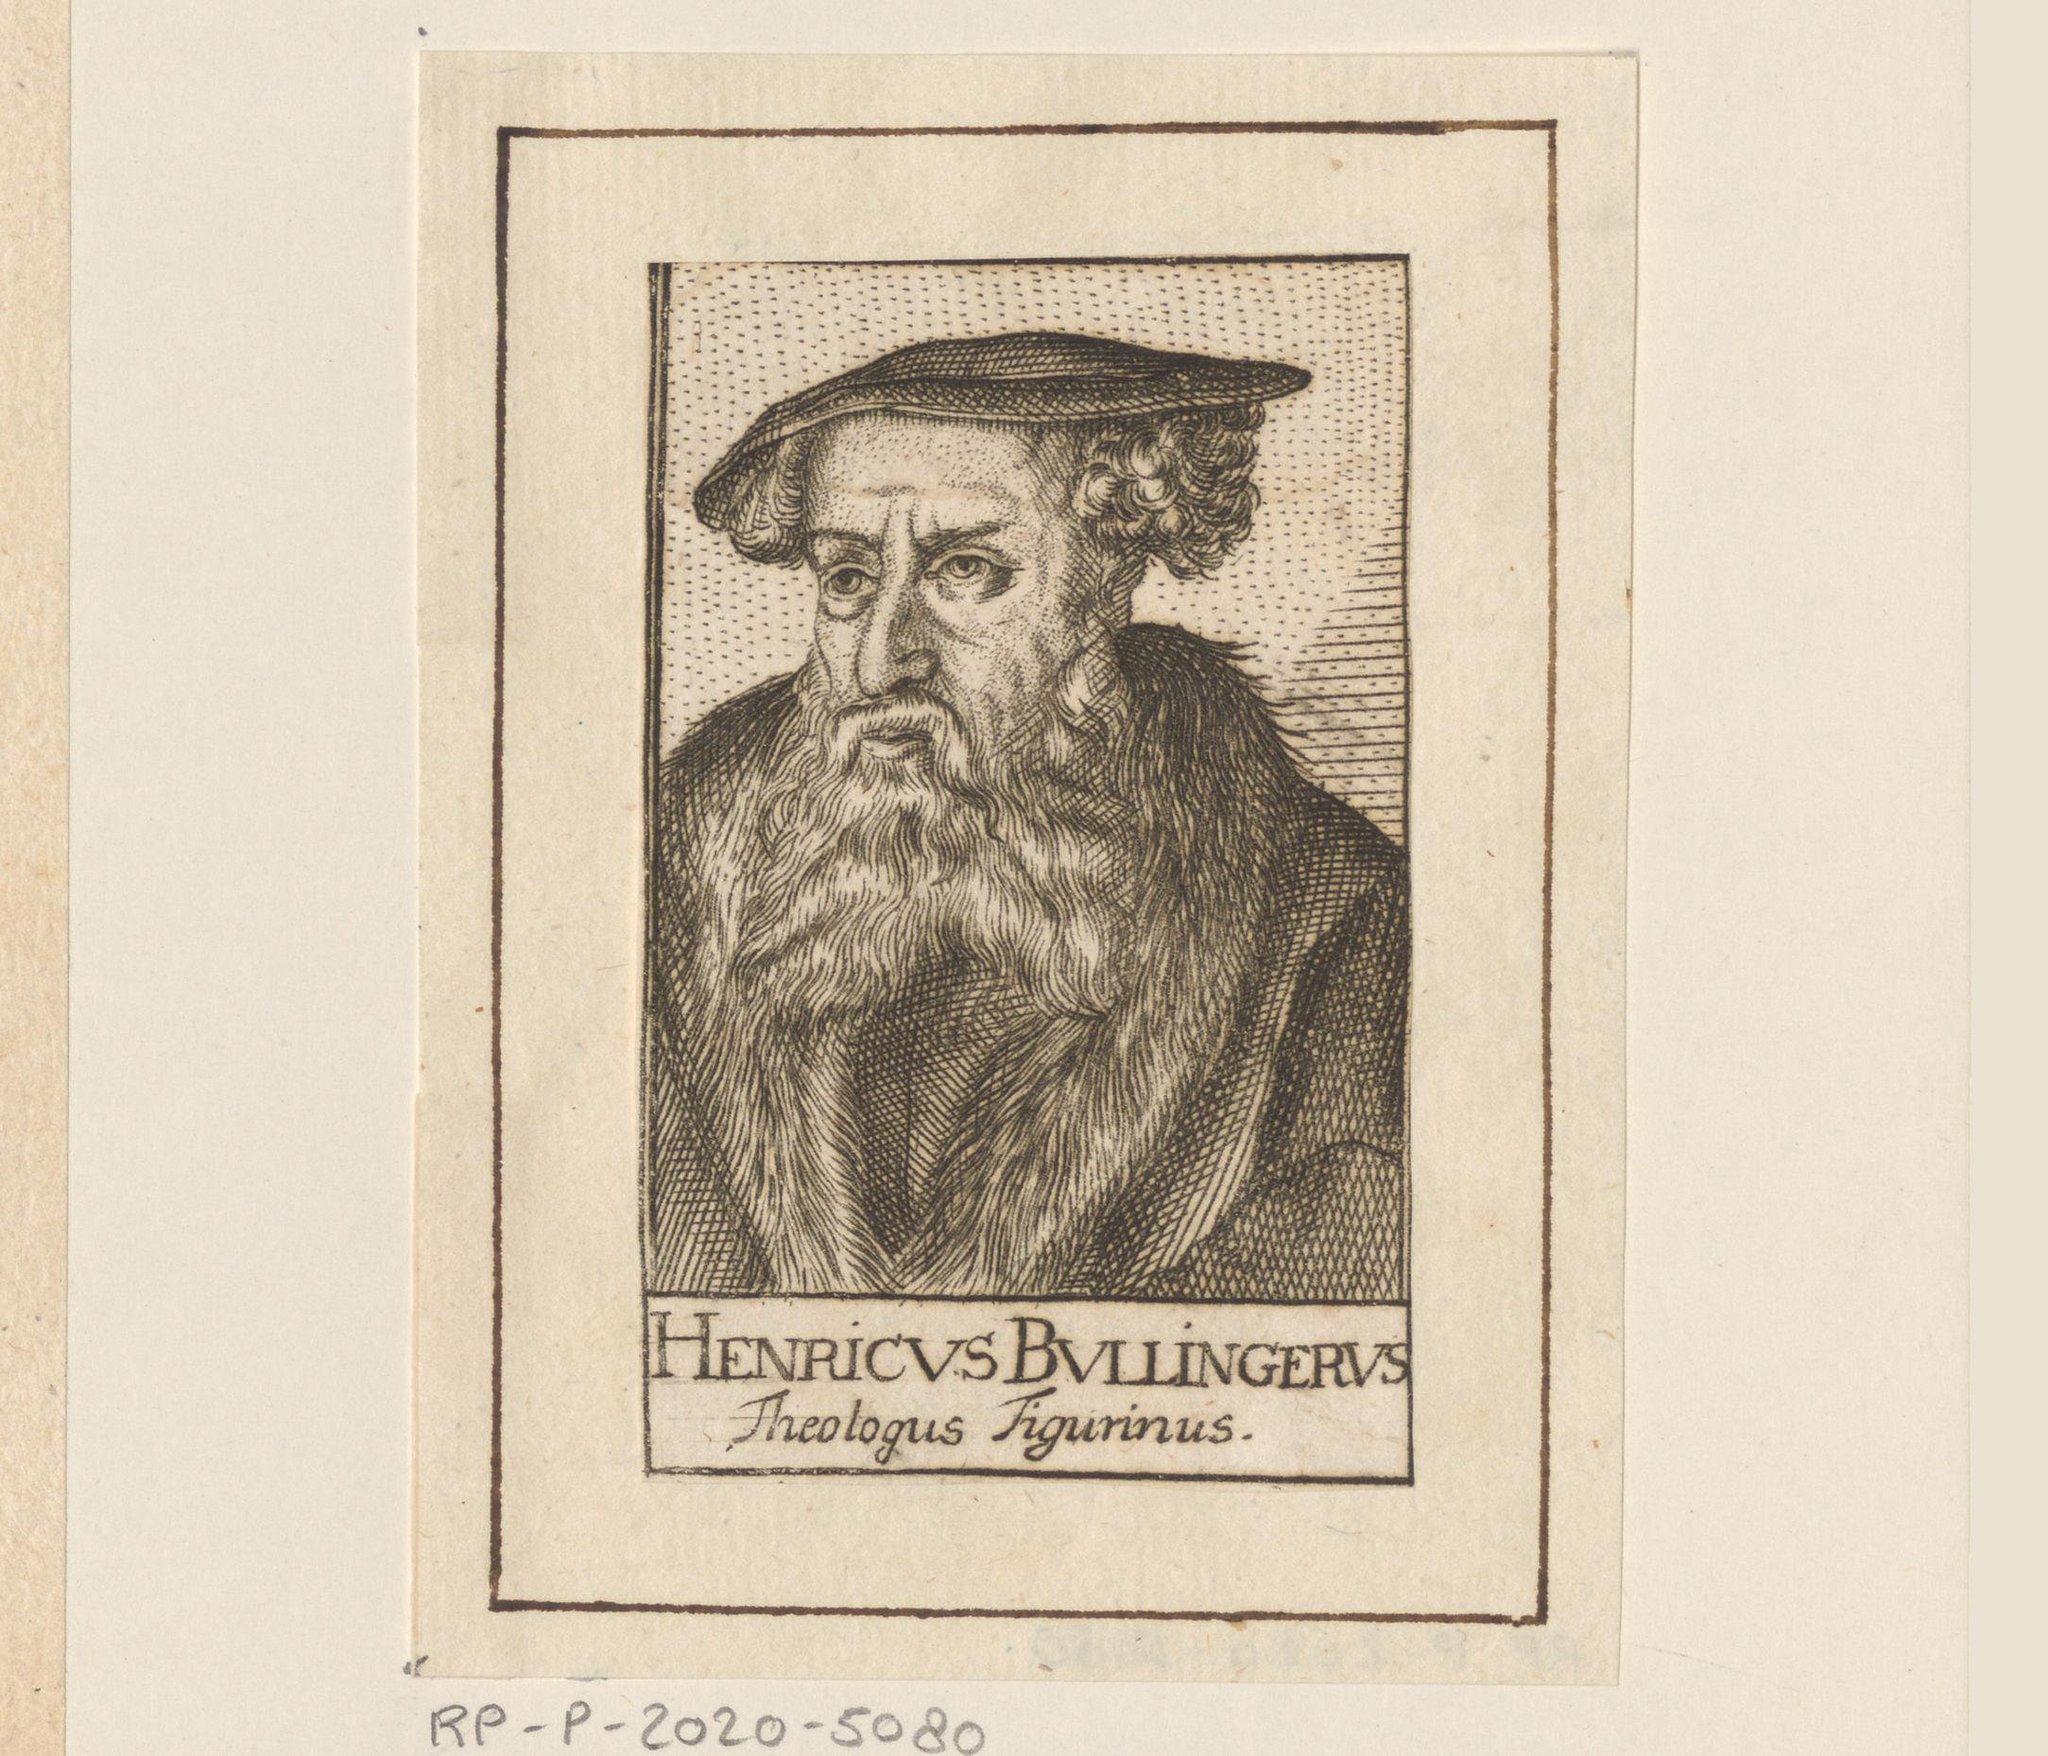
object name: book illustration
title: Portret van Johann Heinrich Bullinger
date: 1688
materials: paper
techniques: engraving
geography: nuremberg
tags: theologian, historical persons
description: Prent uit: Freher, Paul. Theatrum virorum eruditione clarorum. Neurenberg: Johann Hoffmann, 1688.